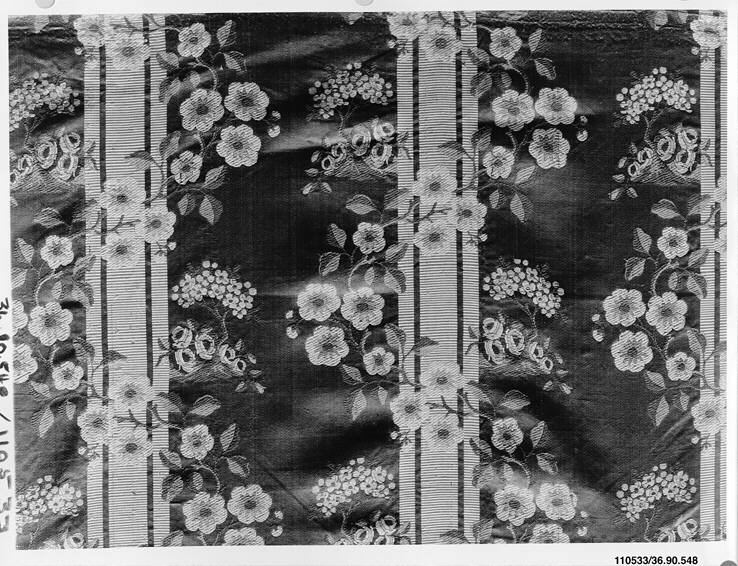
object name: piece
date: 1767-1800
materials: silk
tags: flowers